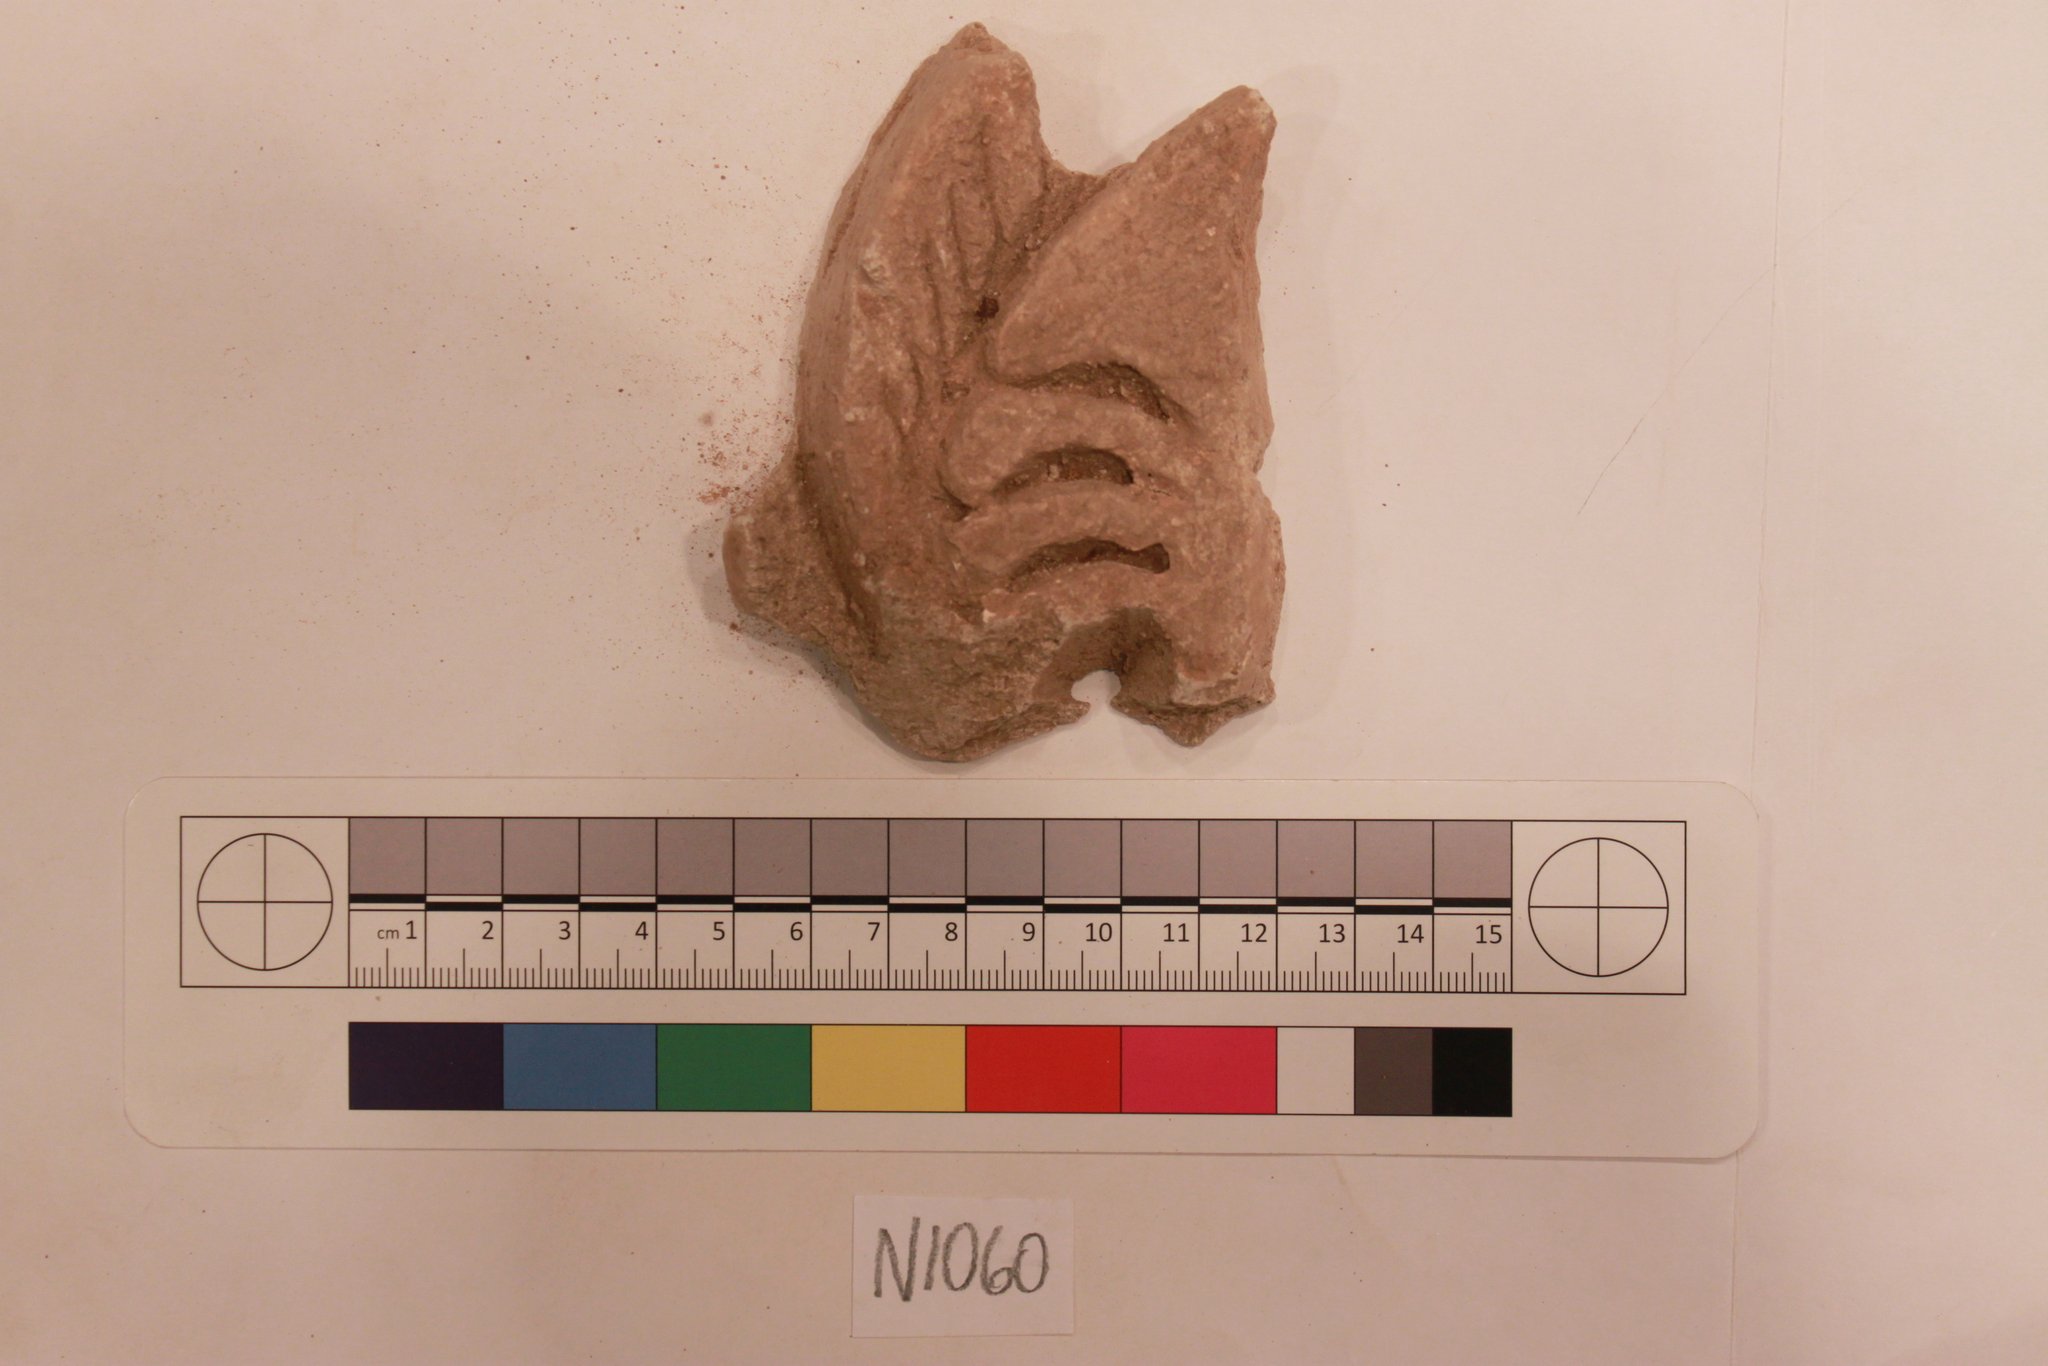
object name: fragment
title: Stucco Fragment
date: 701-1200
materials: plaster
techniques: carving, painting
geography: iran